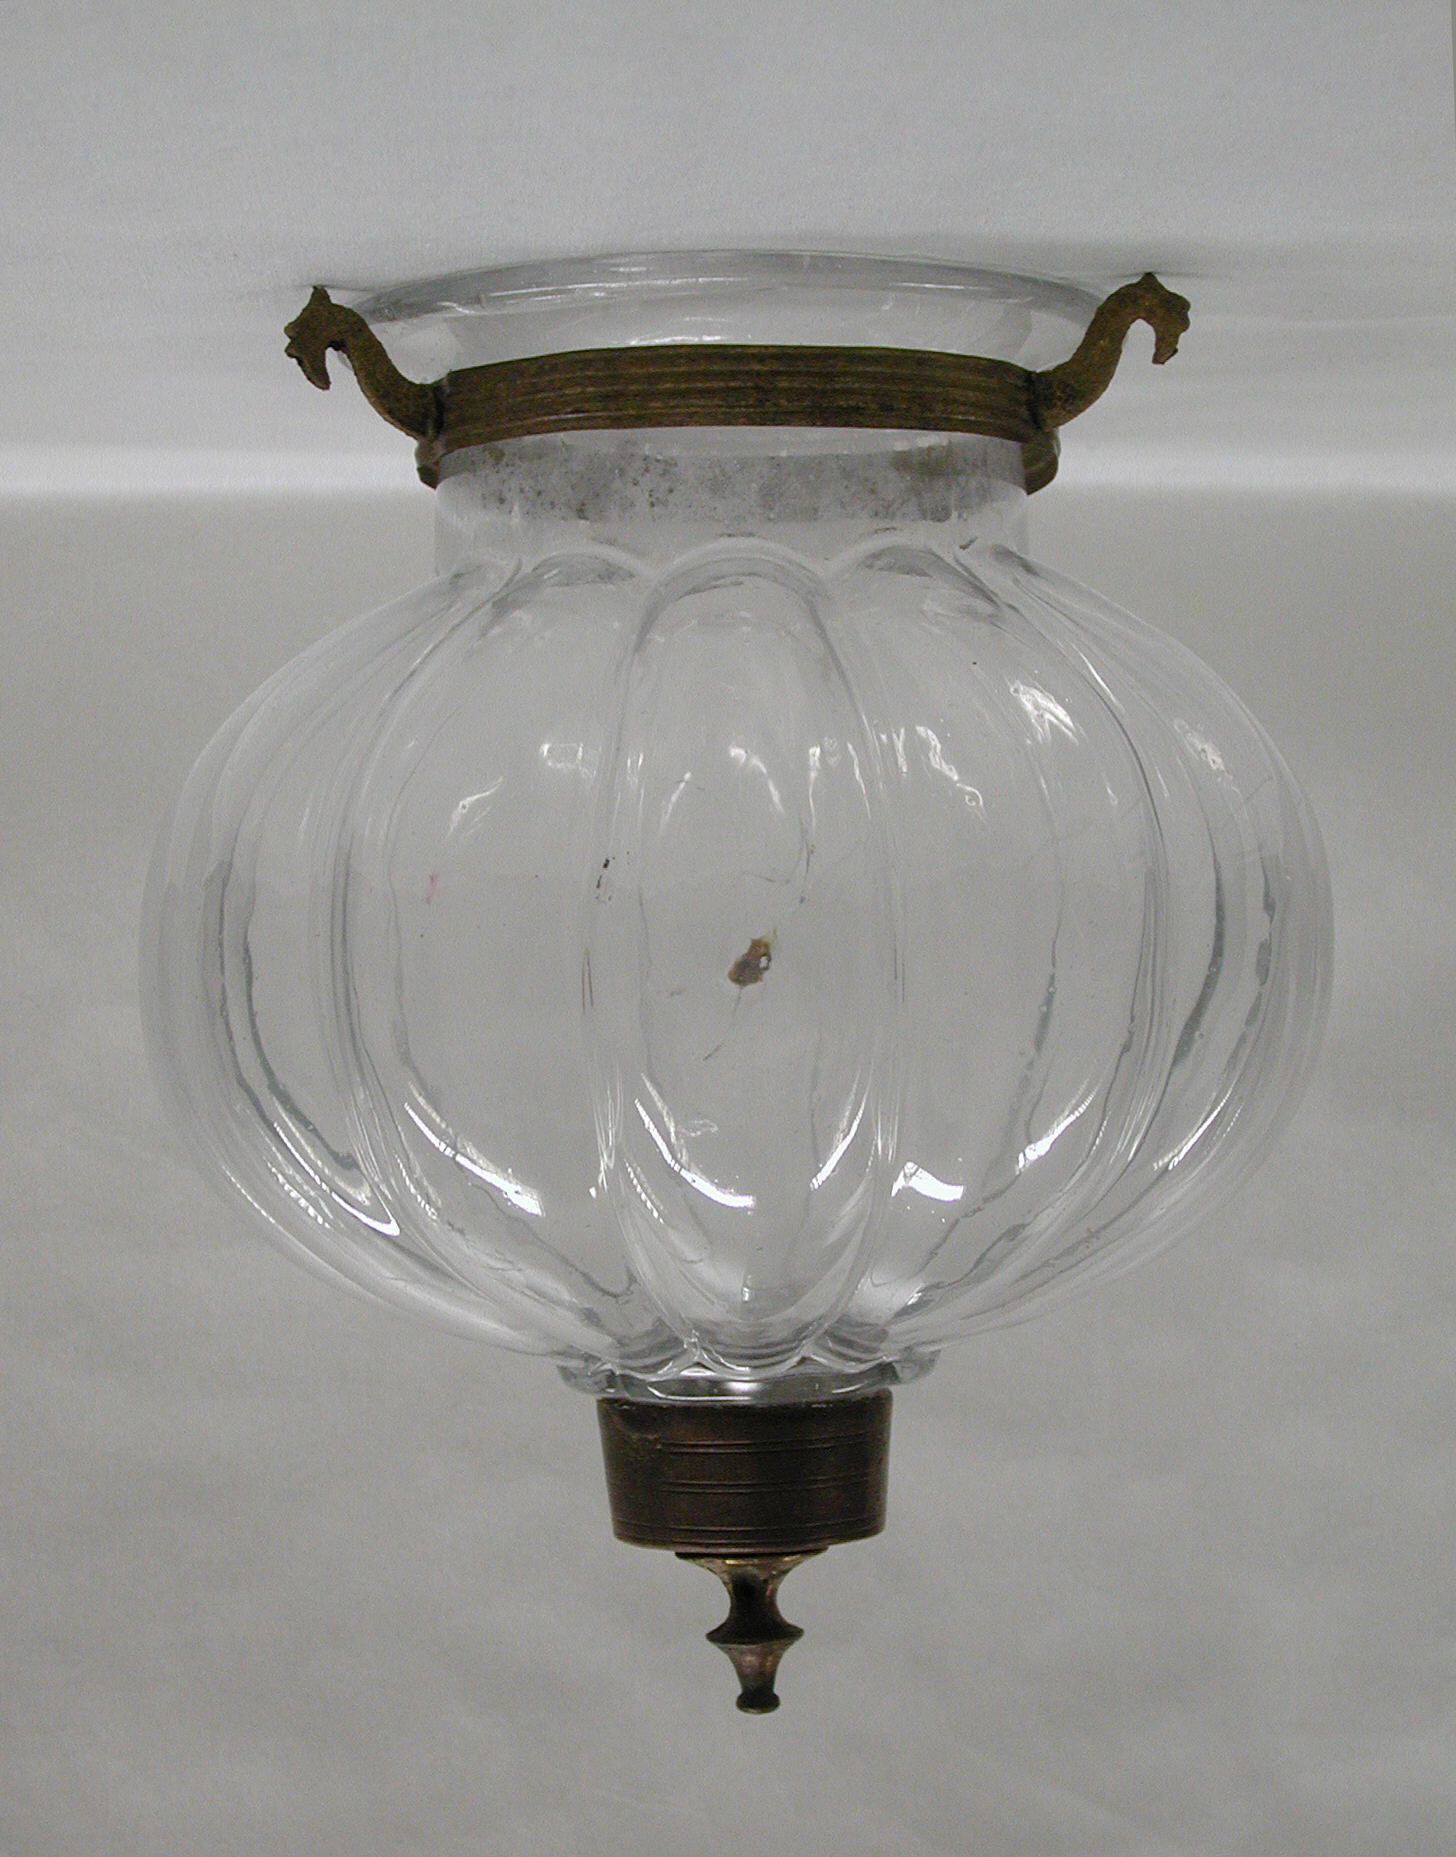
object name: hanging lamp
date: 1601-1700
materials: copper gilt, glass